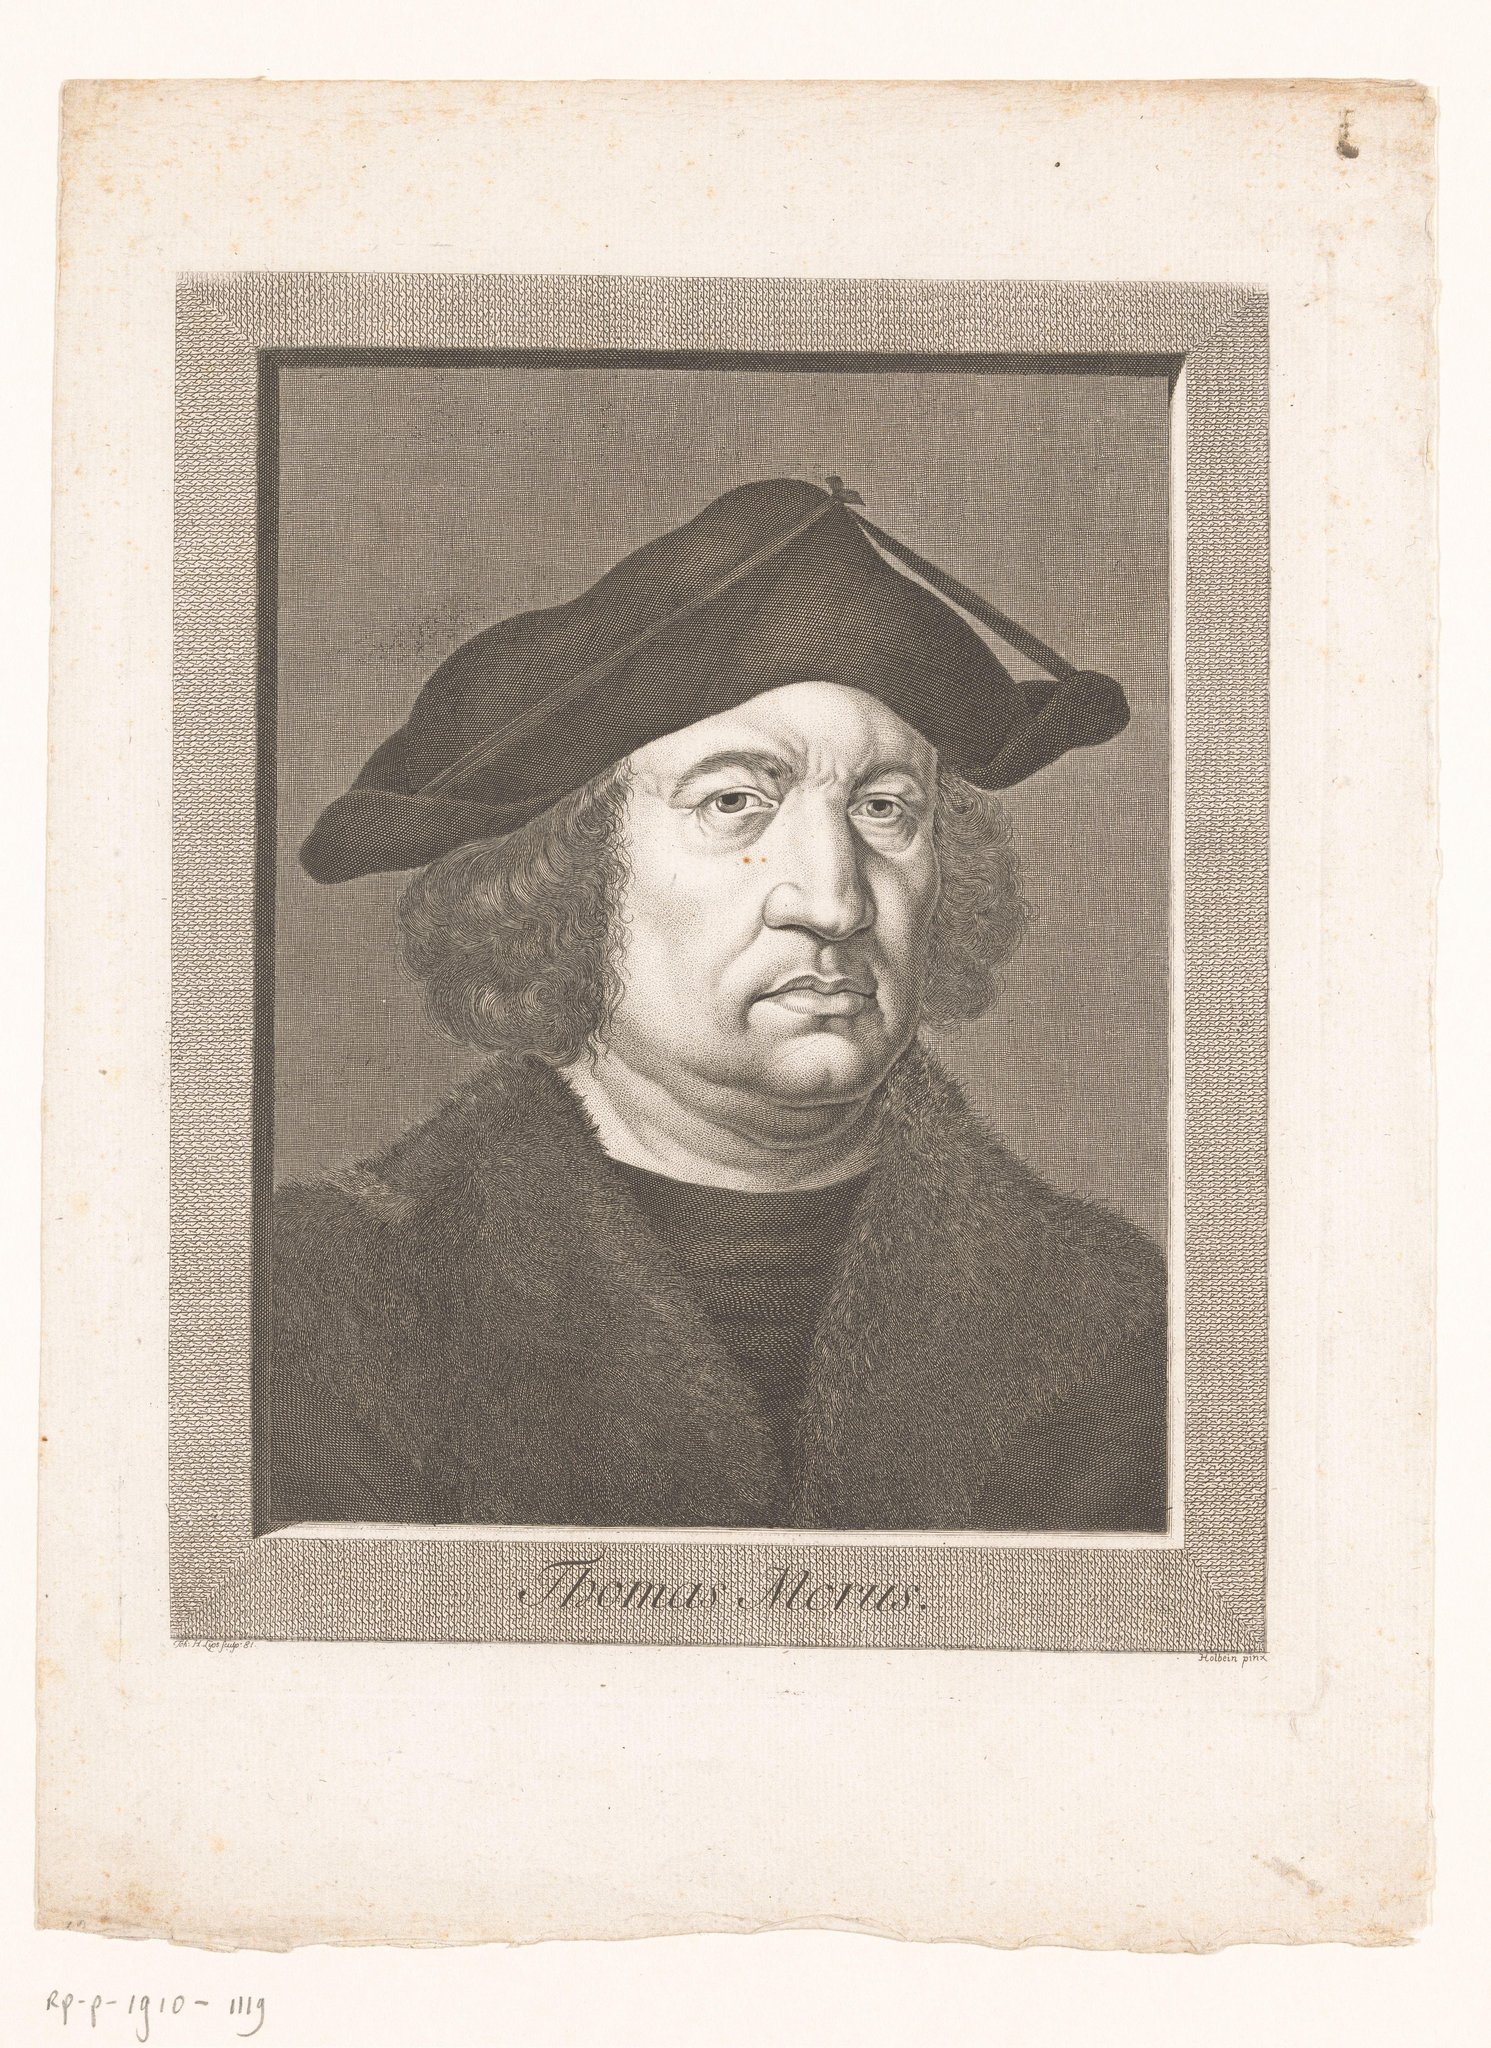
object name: print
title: Portret van Thomas More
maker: johann heinrich lips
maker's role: draughtsman, painter, print maker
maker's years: 1758-1817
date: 1781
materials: paper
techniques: etching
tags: london, historical persons, portrait of a writer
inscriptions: collector's mark: Lugt 2228